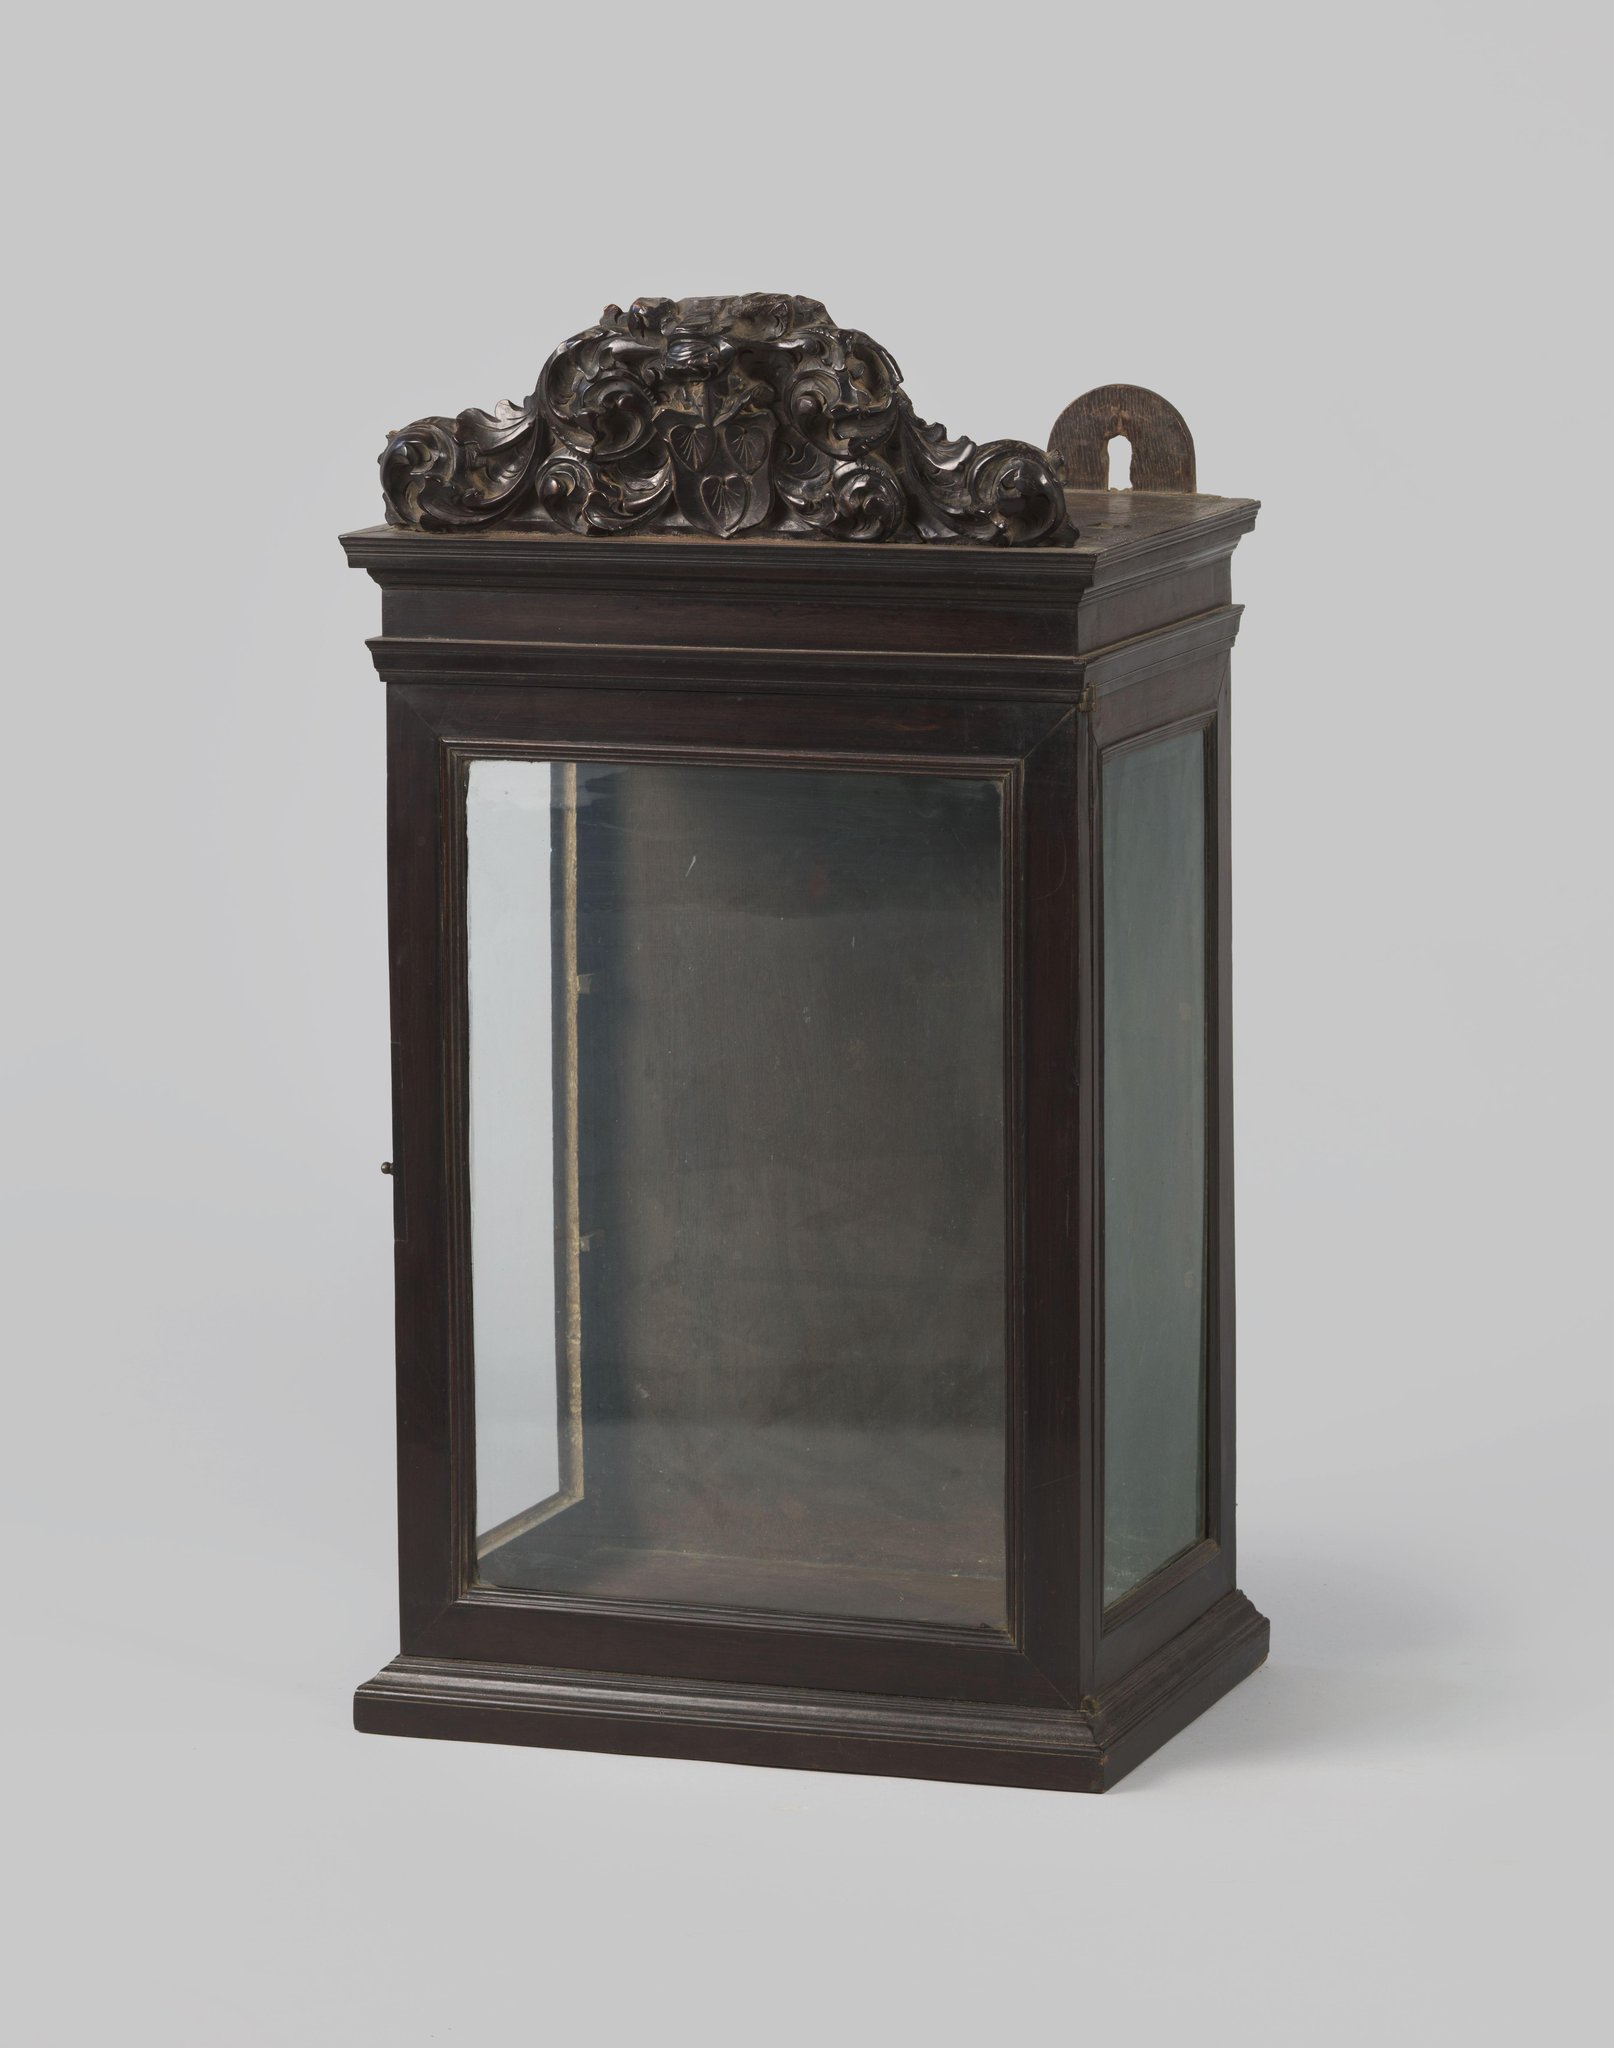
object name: case furniture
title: Vitrinekast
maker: Anonymous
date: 1600-1699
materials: wood, glass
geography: northern netherlands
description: Vitrinekast belegd met ebbenhout, aan de voorzijde afgesloten door een deur met glasruit. De strak geprofileerde kroonlijst draagt een opzetstuk bestaande uit voluten met lofwerk, met in het midden een wapenschild met drie hartvormige bladeren, geplaatst onder een helmteken.